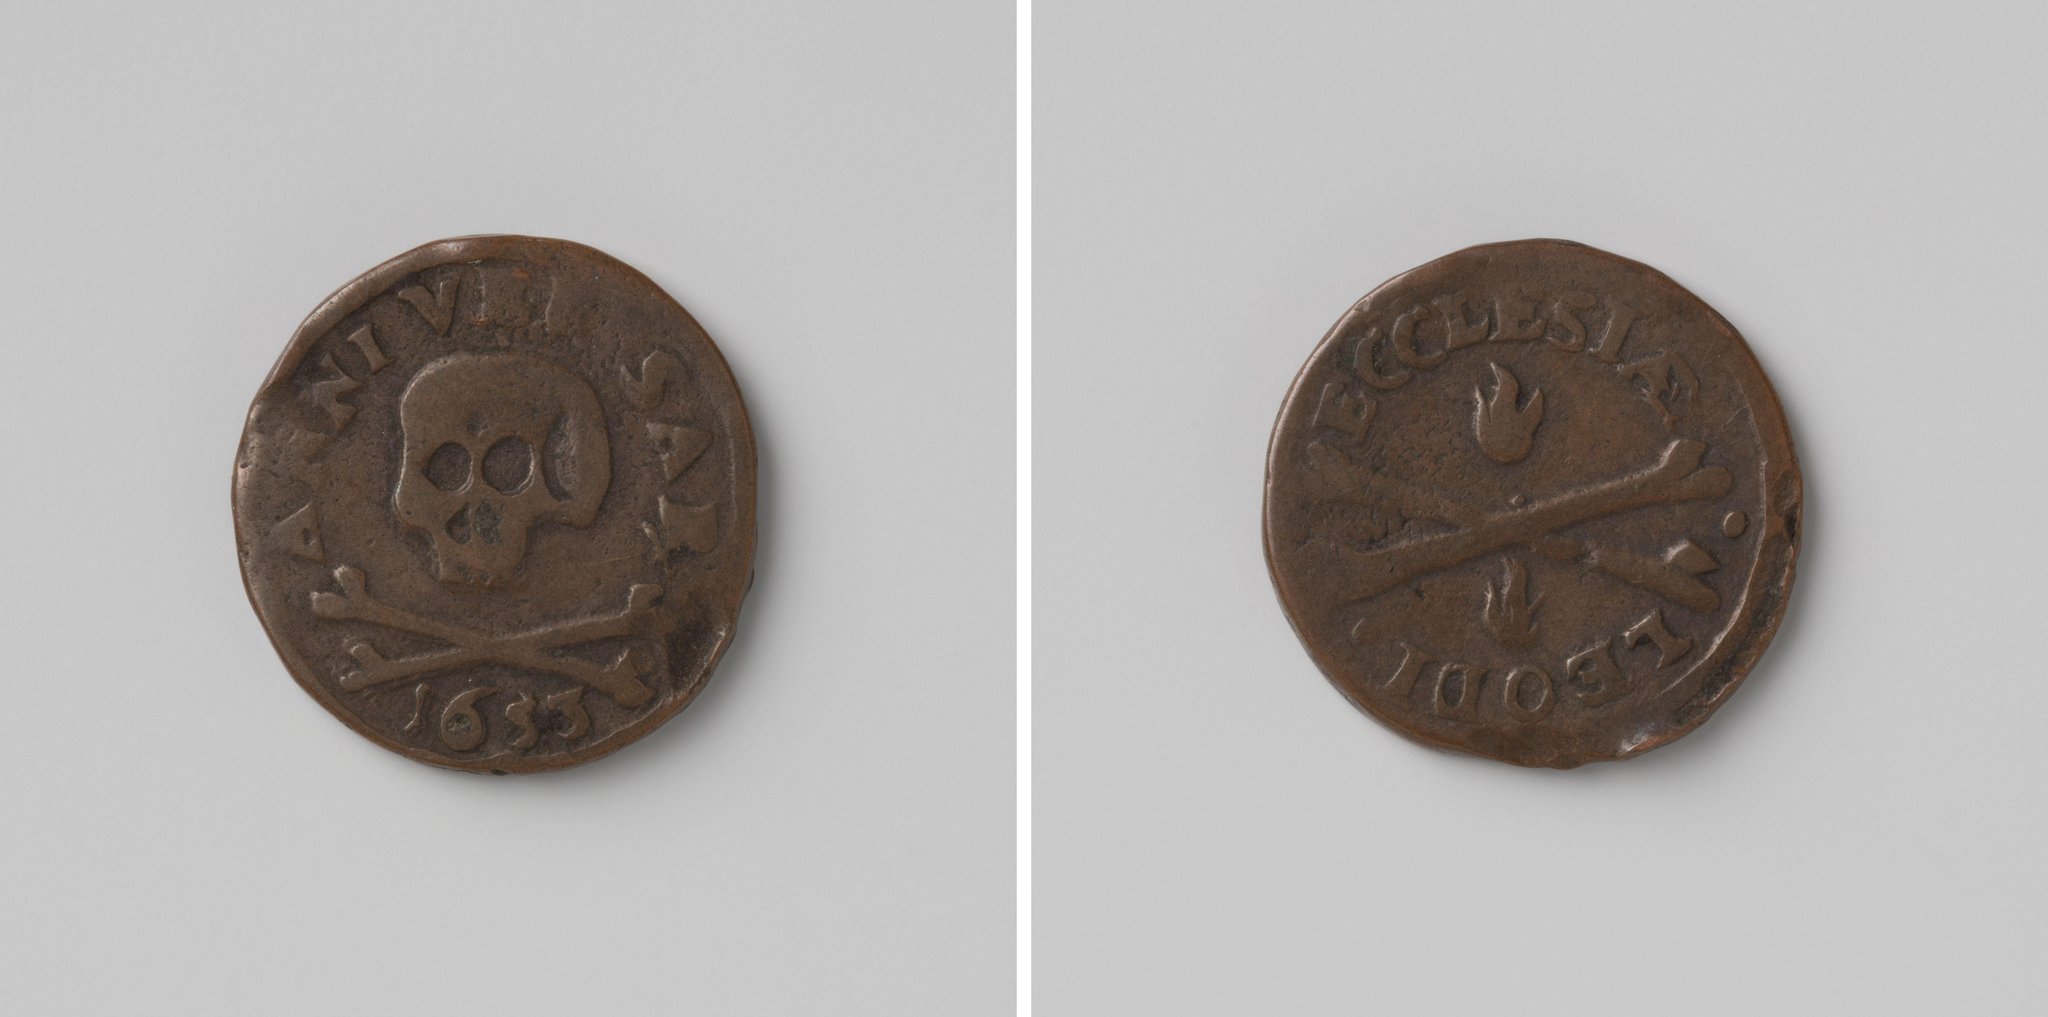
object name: devotional medal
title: Kerk van Luik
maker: Anonymous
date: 1653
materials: copper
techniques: striking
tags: liège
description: Koperen penning. Voorzijde: doodshoofd boven twee gekruiste beenderen en jaartal binnen omschrift. Keerzijde: twee gekruiste beenderen; daartussen twee vonken binnen omschrift